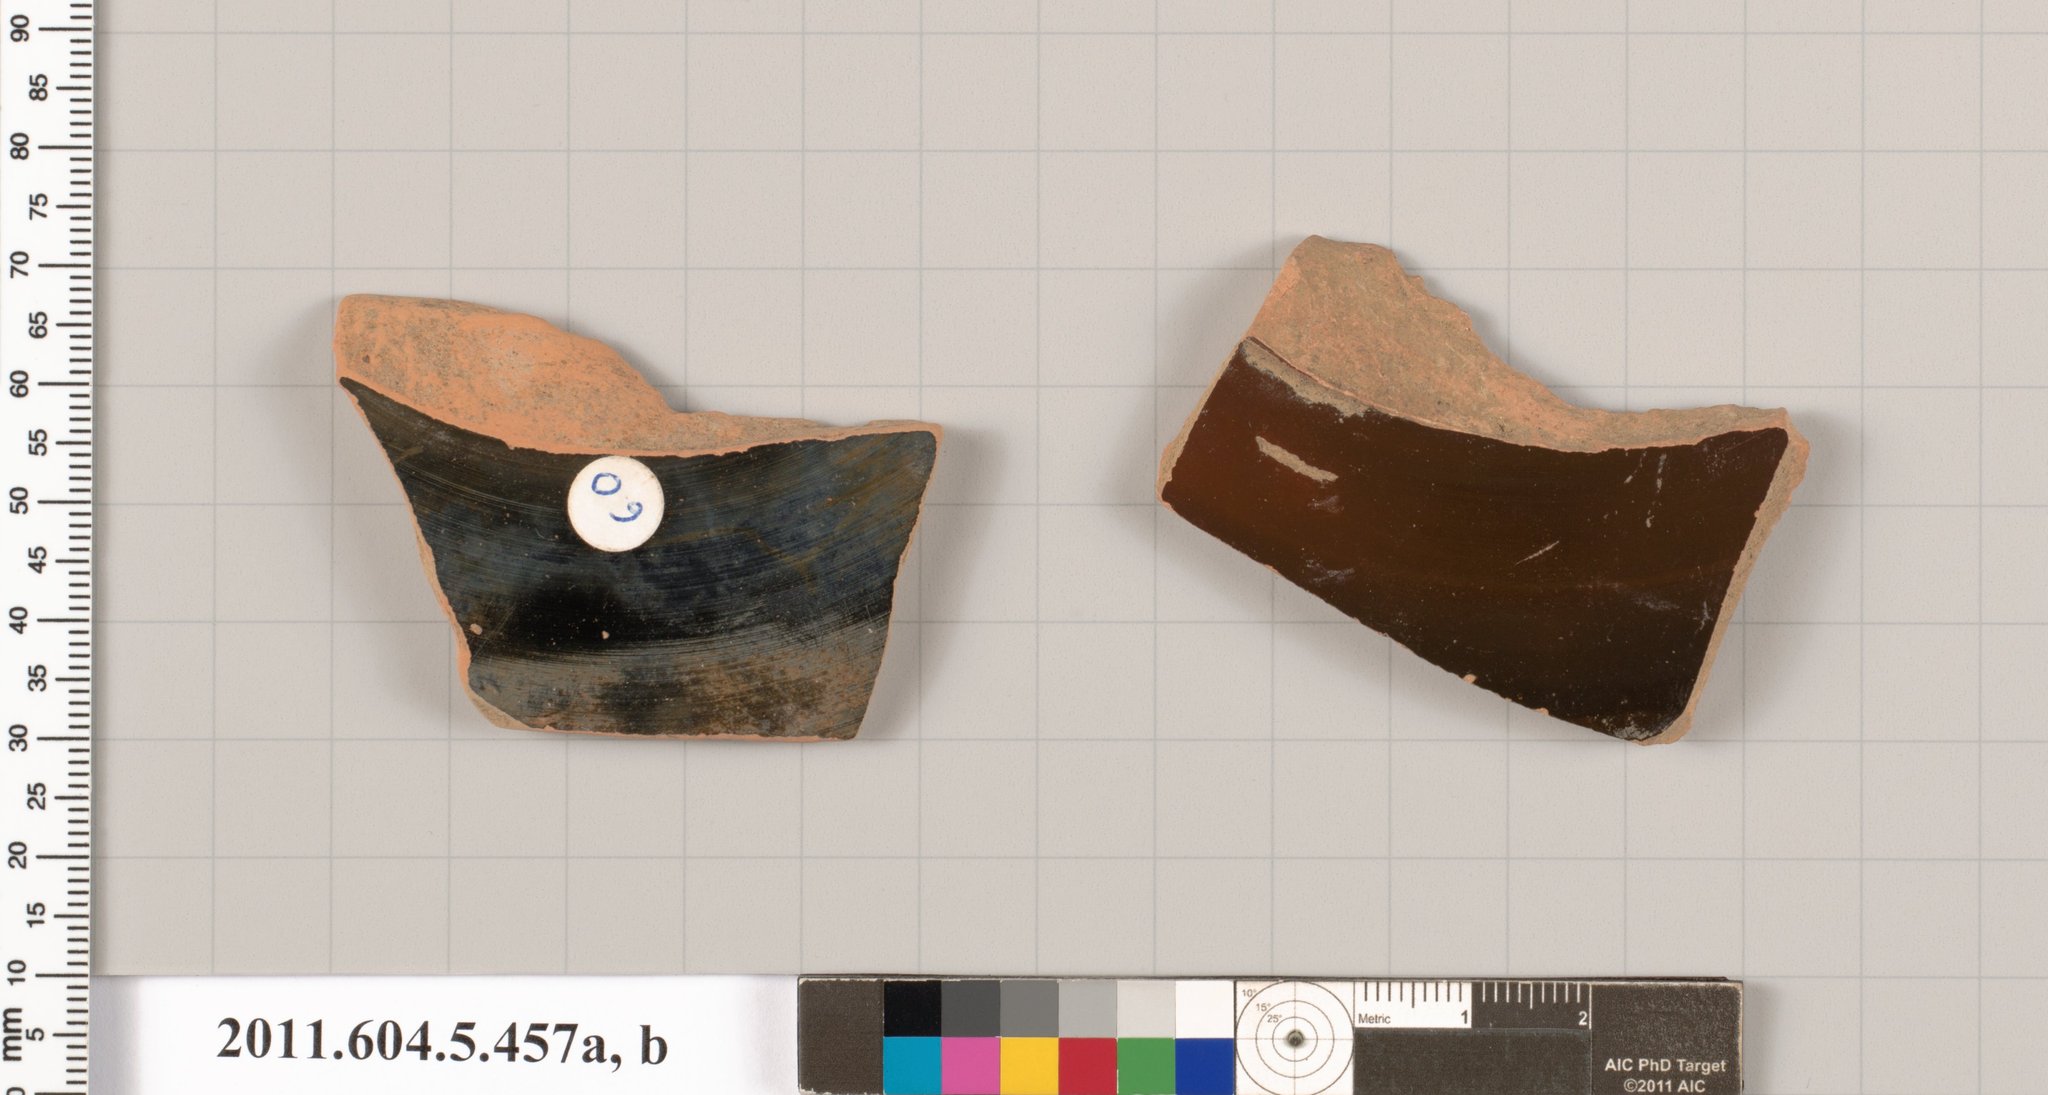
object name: kylix fragment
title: Terracotta fragments of kylikes (drinking cups)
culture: greek, attic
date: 600-401 BCE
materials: terracotta